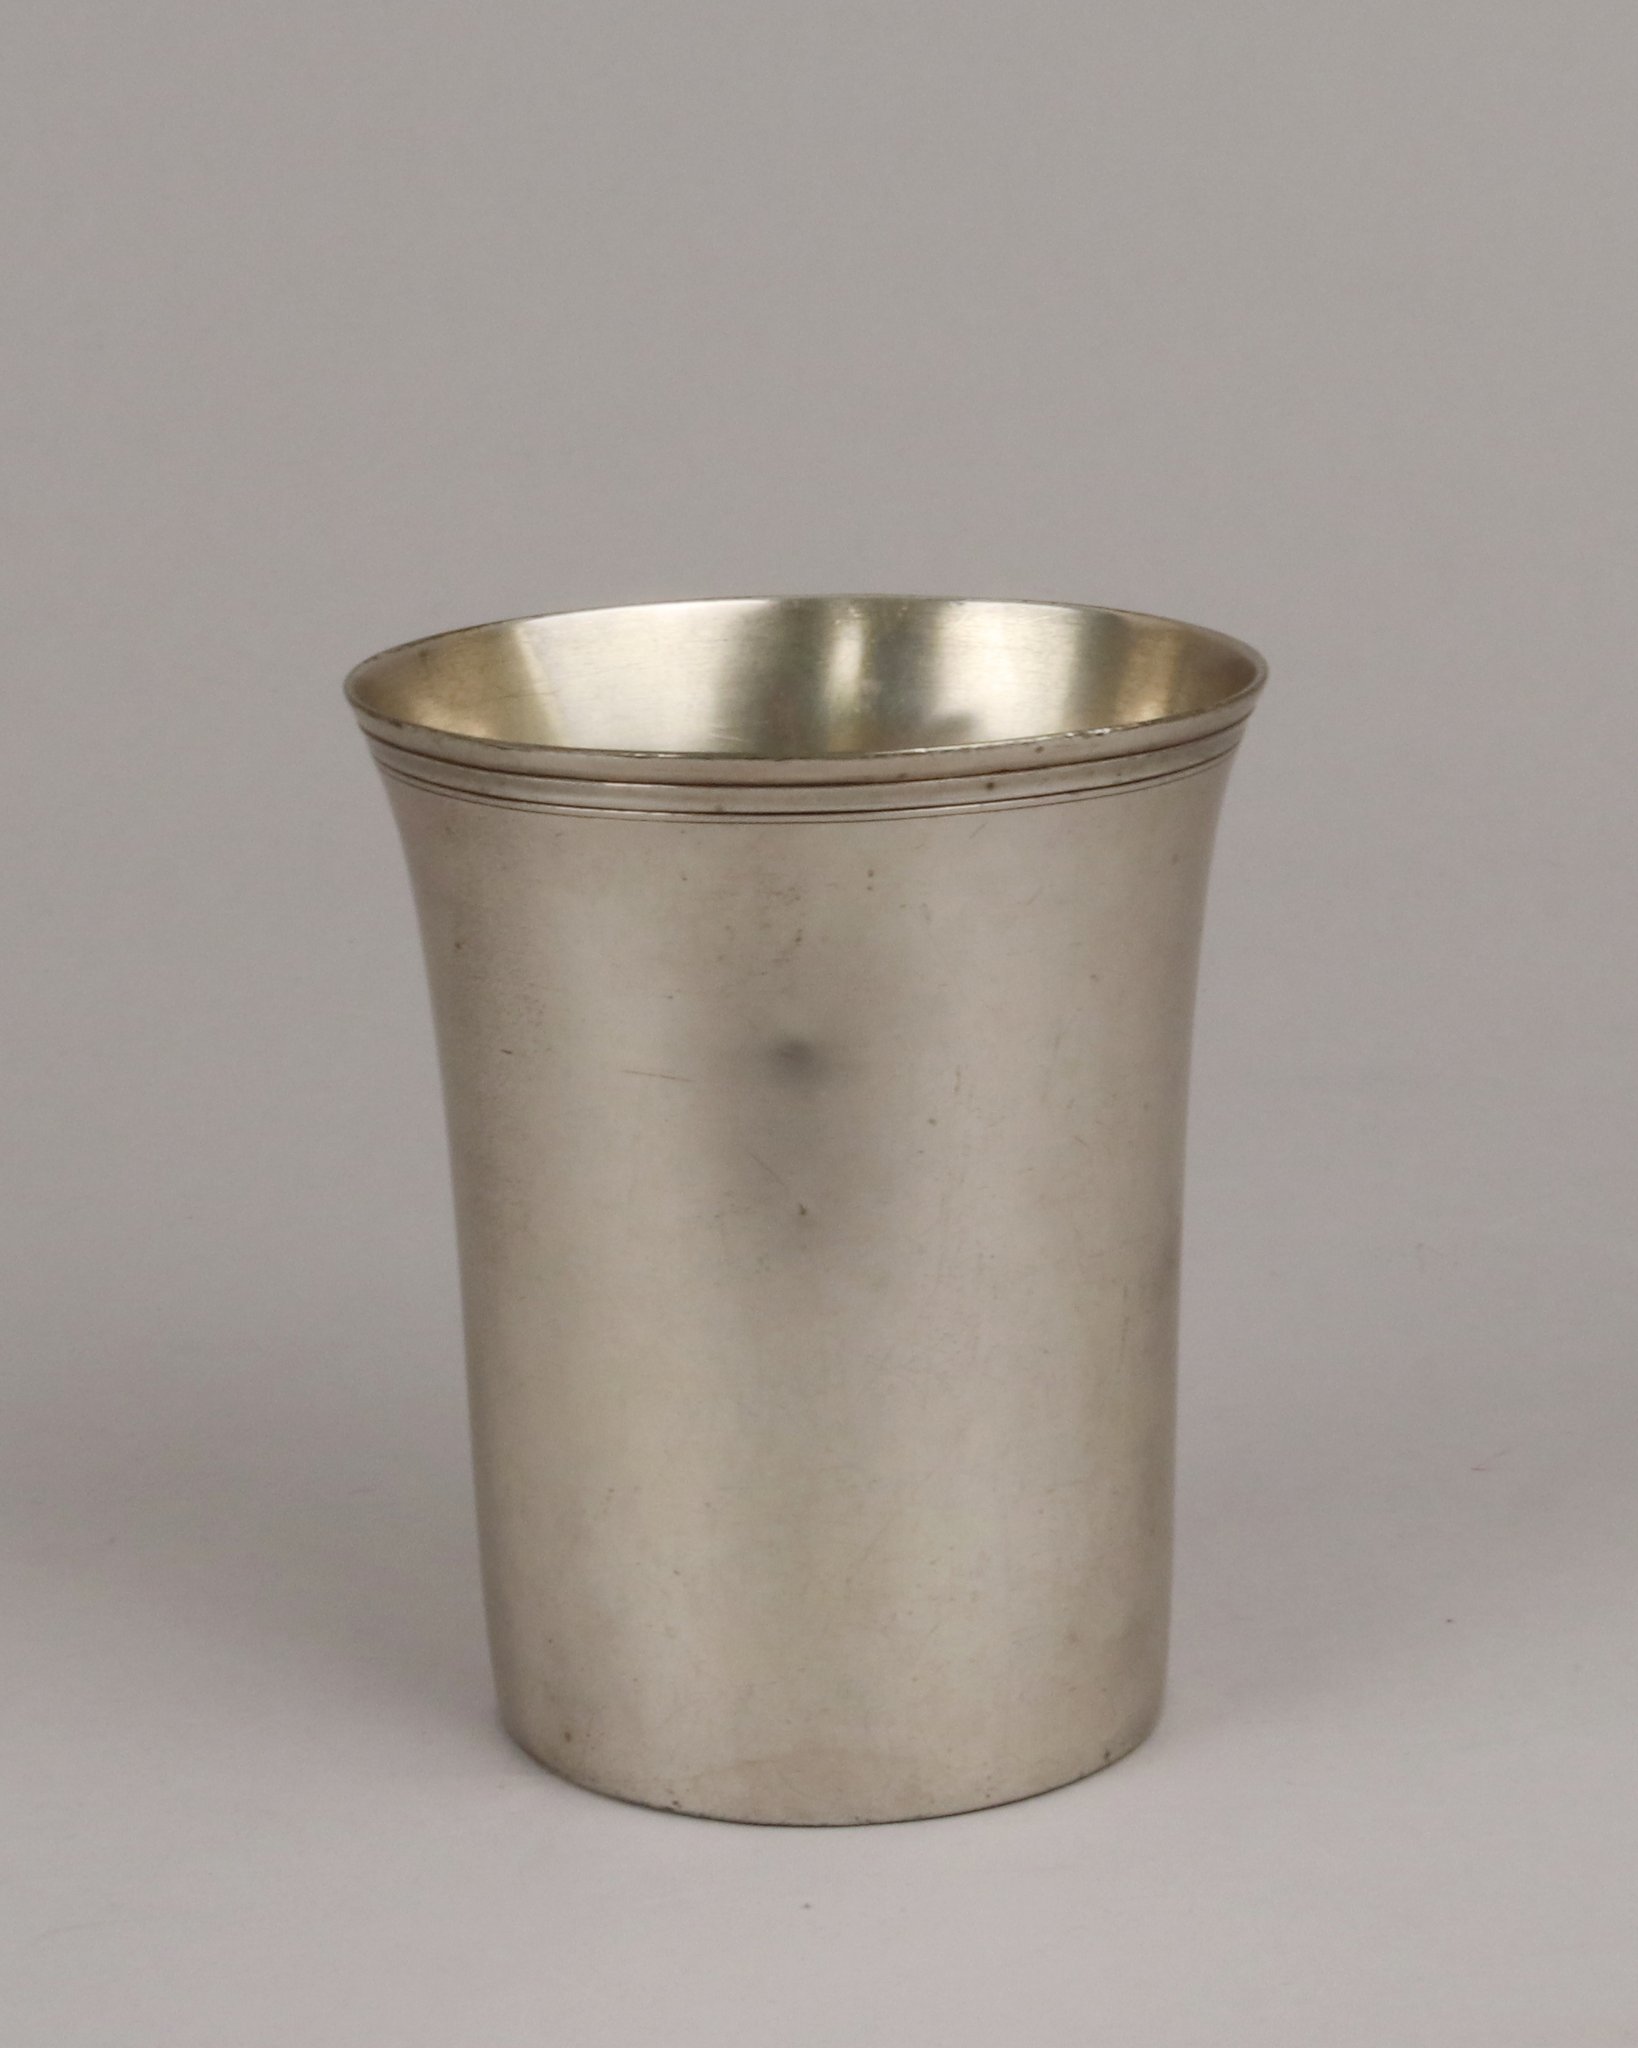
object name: beaker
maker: f. c., oporto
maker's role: maker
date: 1810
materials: silver